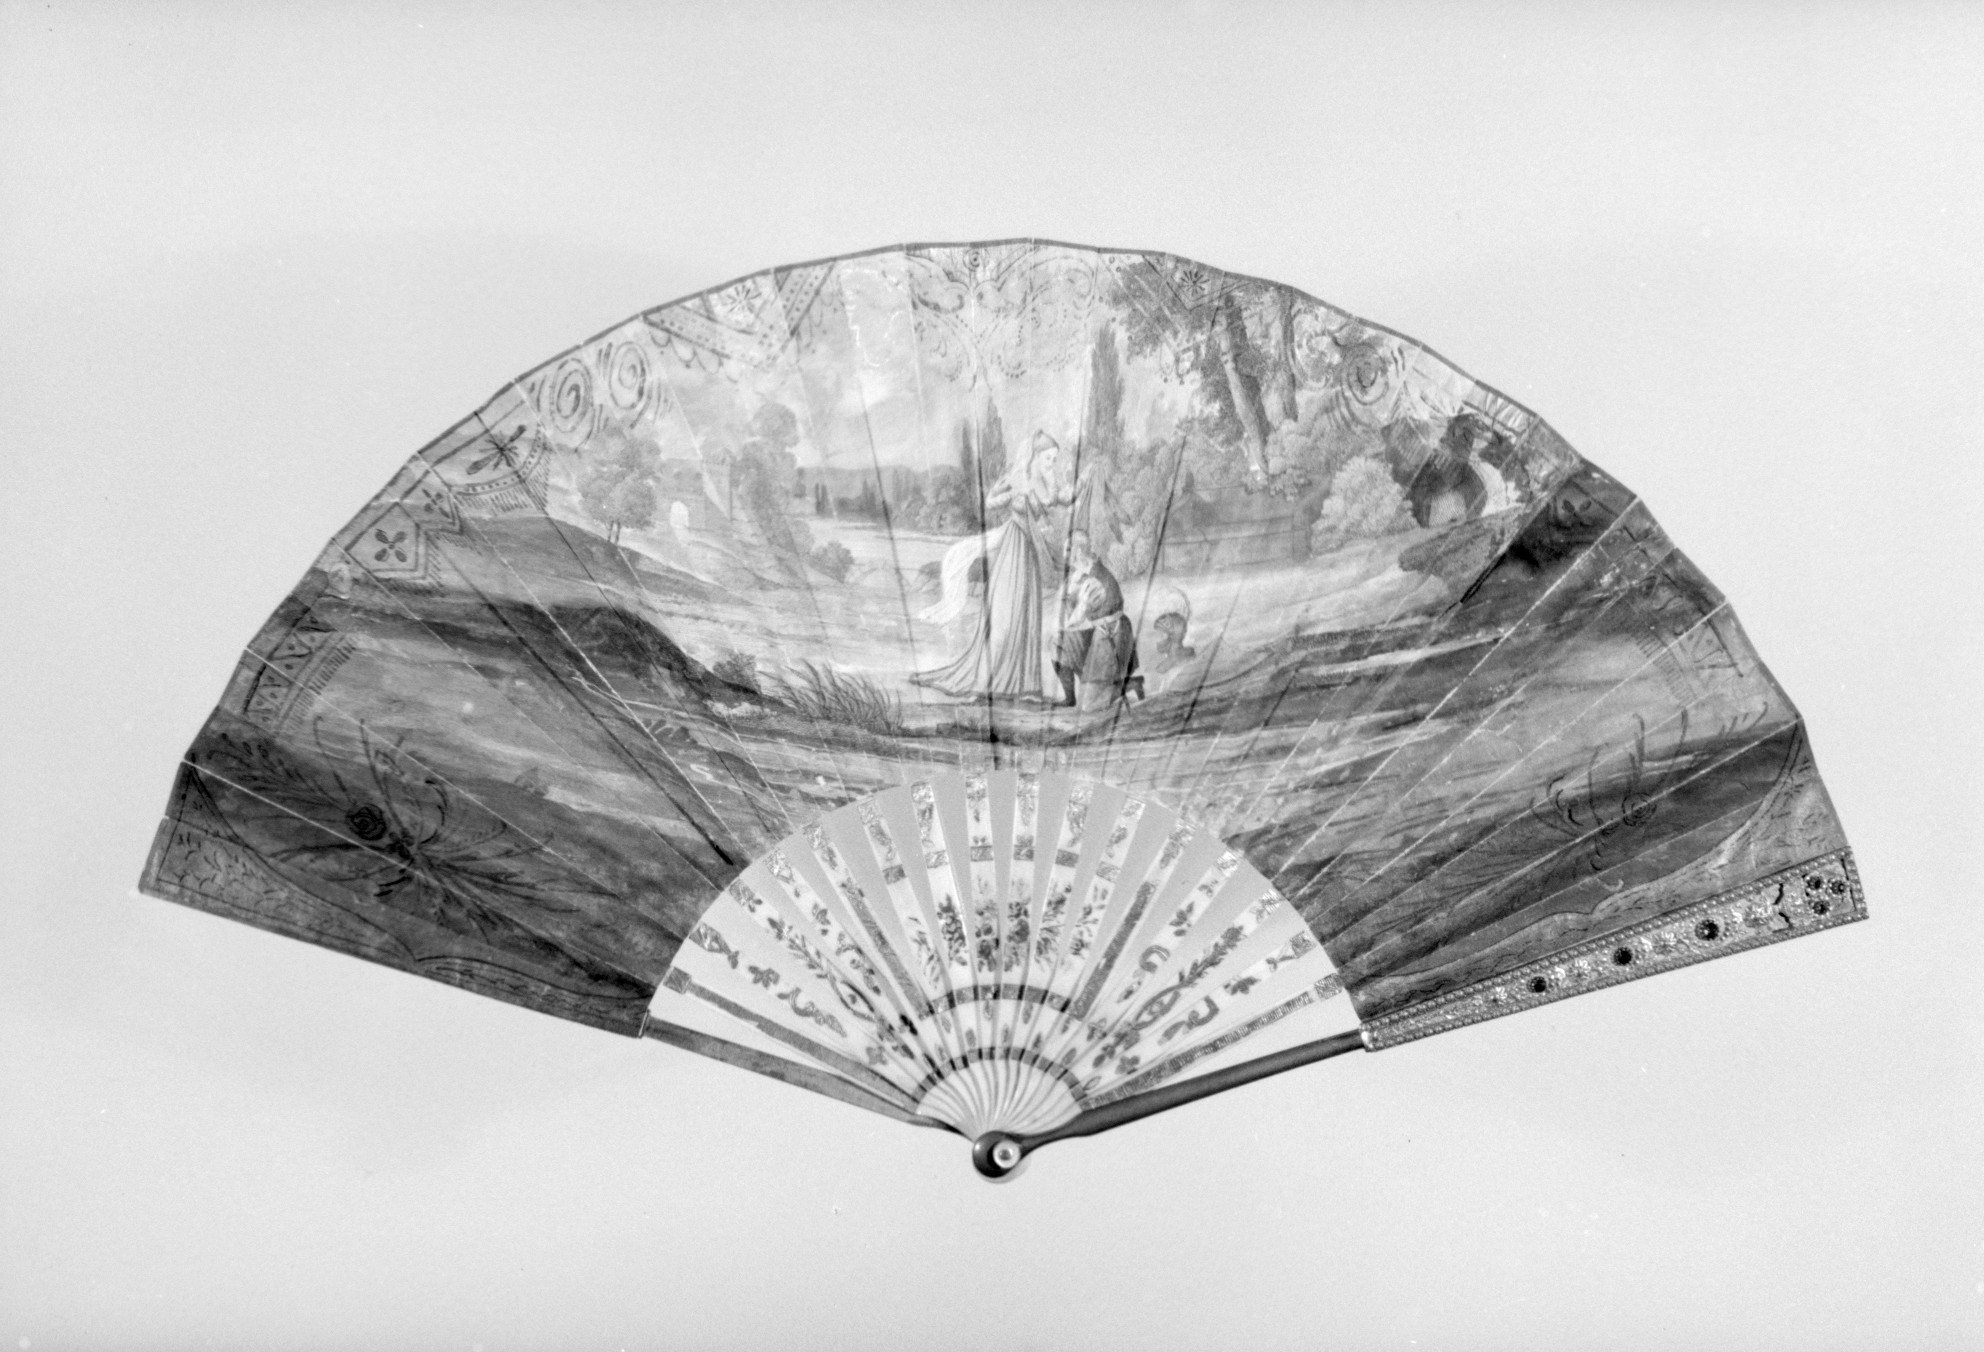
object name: fan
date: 1825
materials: gilt, glass, ivory, metal, mother of pearl, paint, paper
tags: men,women